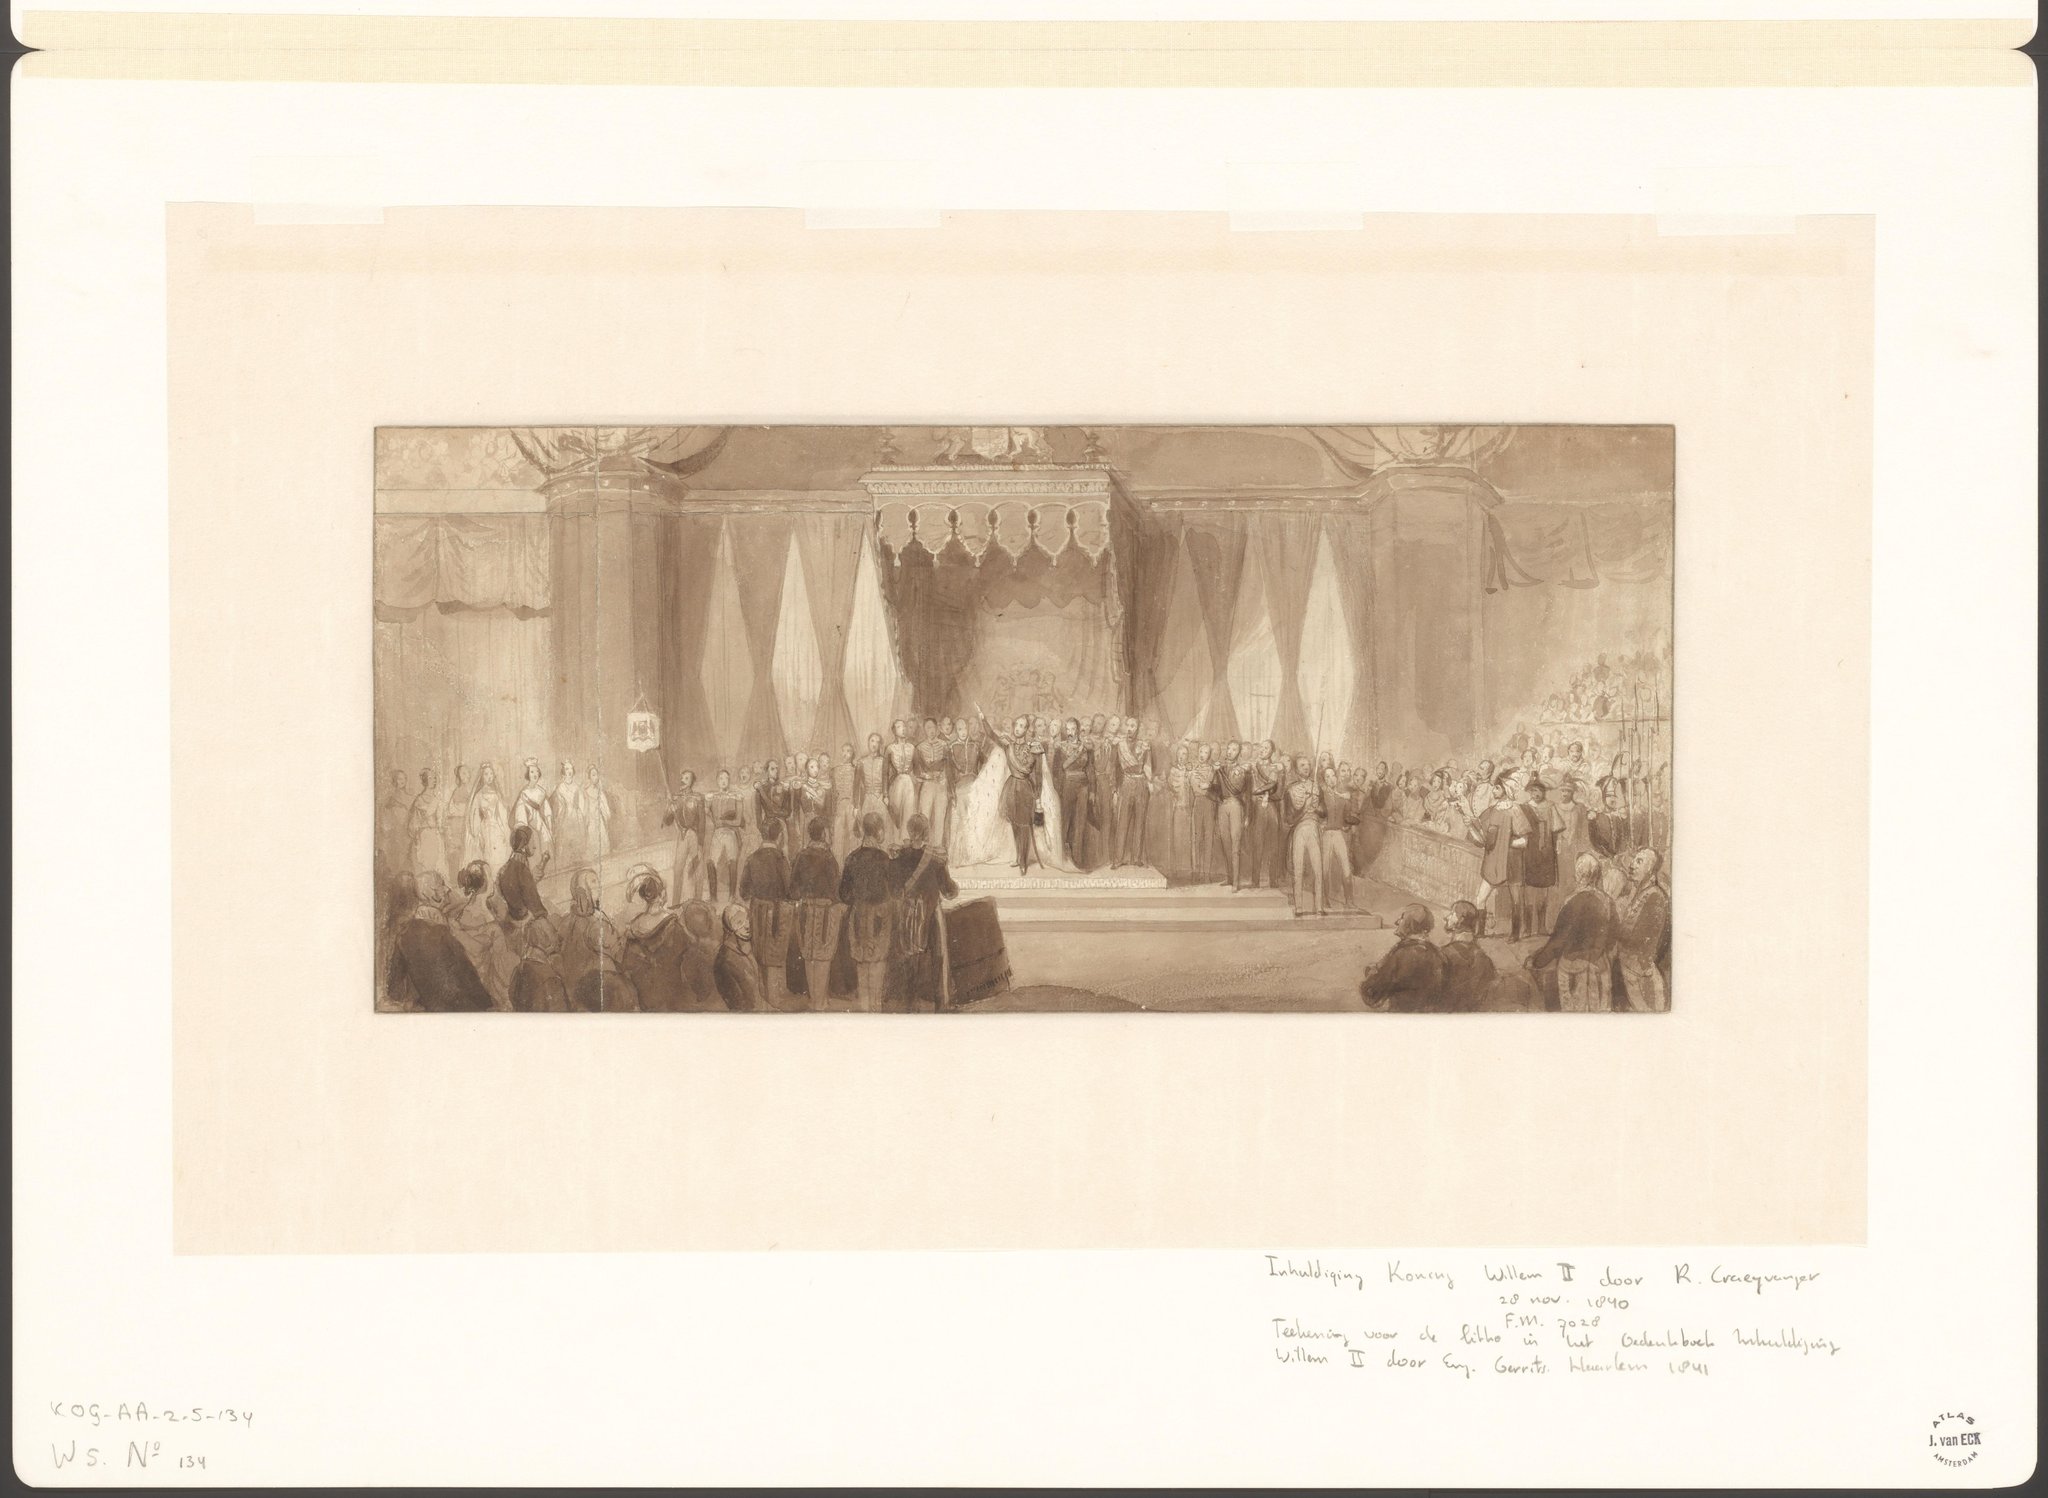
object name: drawing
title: Inhuldiging van koning Willem II in de Nieuwe Kerk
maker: reinier craeyvanger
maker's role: draughtsman, print maker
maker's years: 1812-1880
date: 1840-1880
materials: ink, paper, pencil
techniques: brush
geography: amsterdam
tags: interior of church, during the coronation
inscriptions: collector's mark: Lugt 800a, inscription: ‘ii22’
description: Tekening binnen de Atlas Van Eck ingedeeld op wijknummer 5.